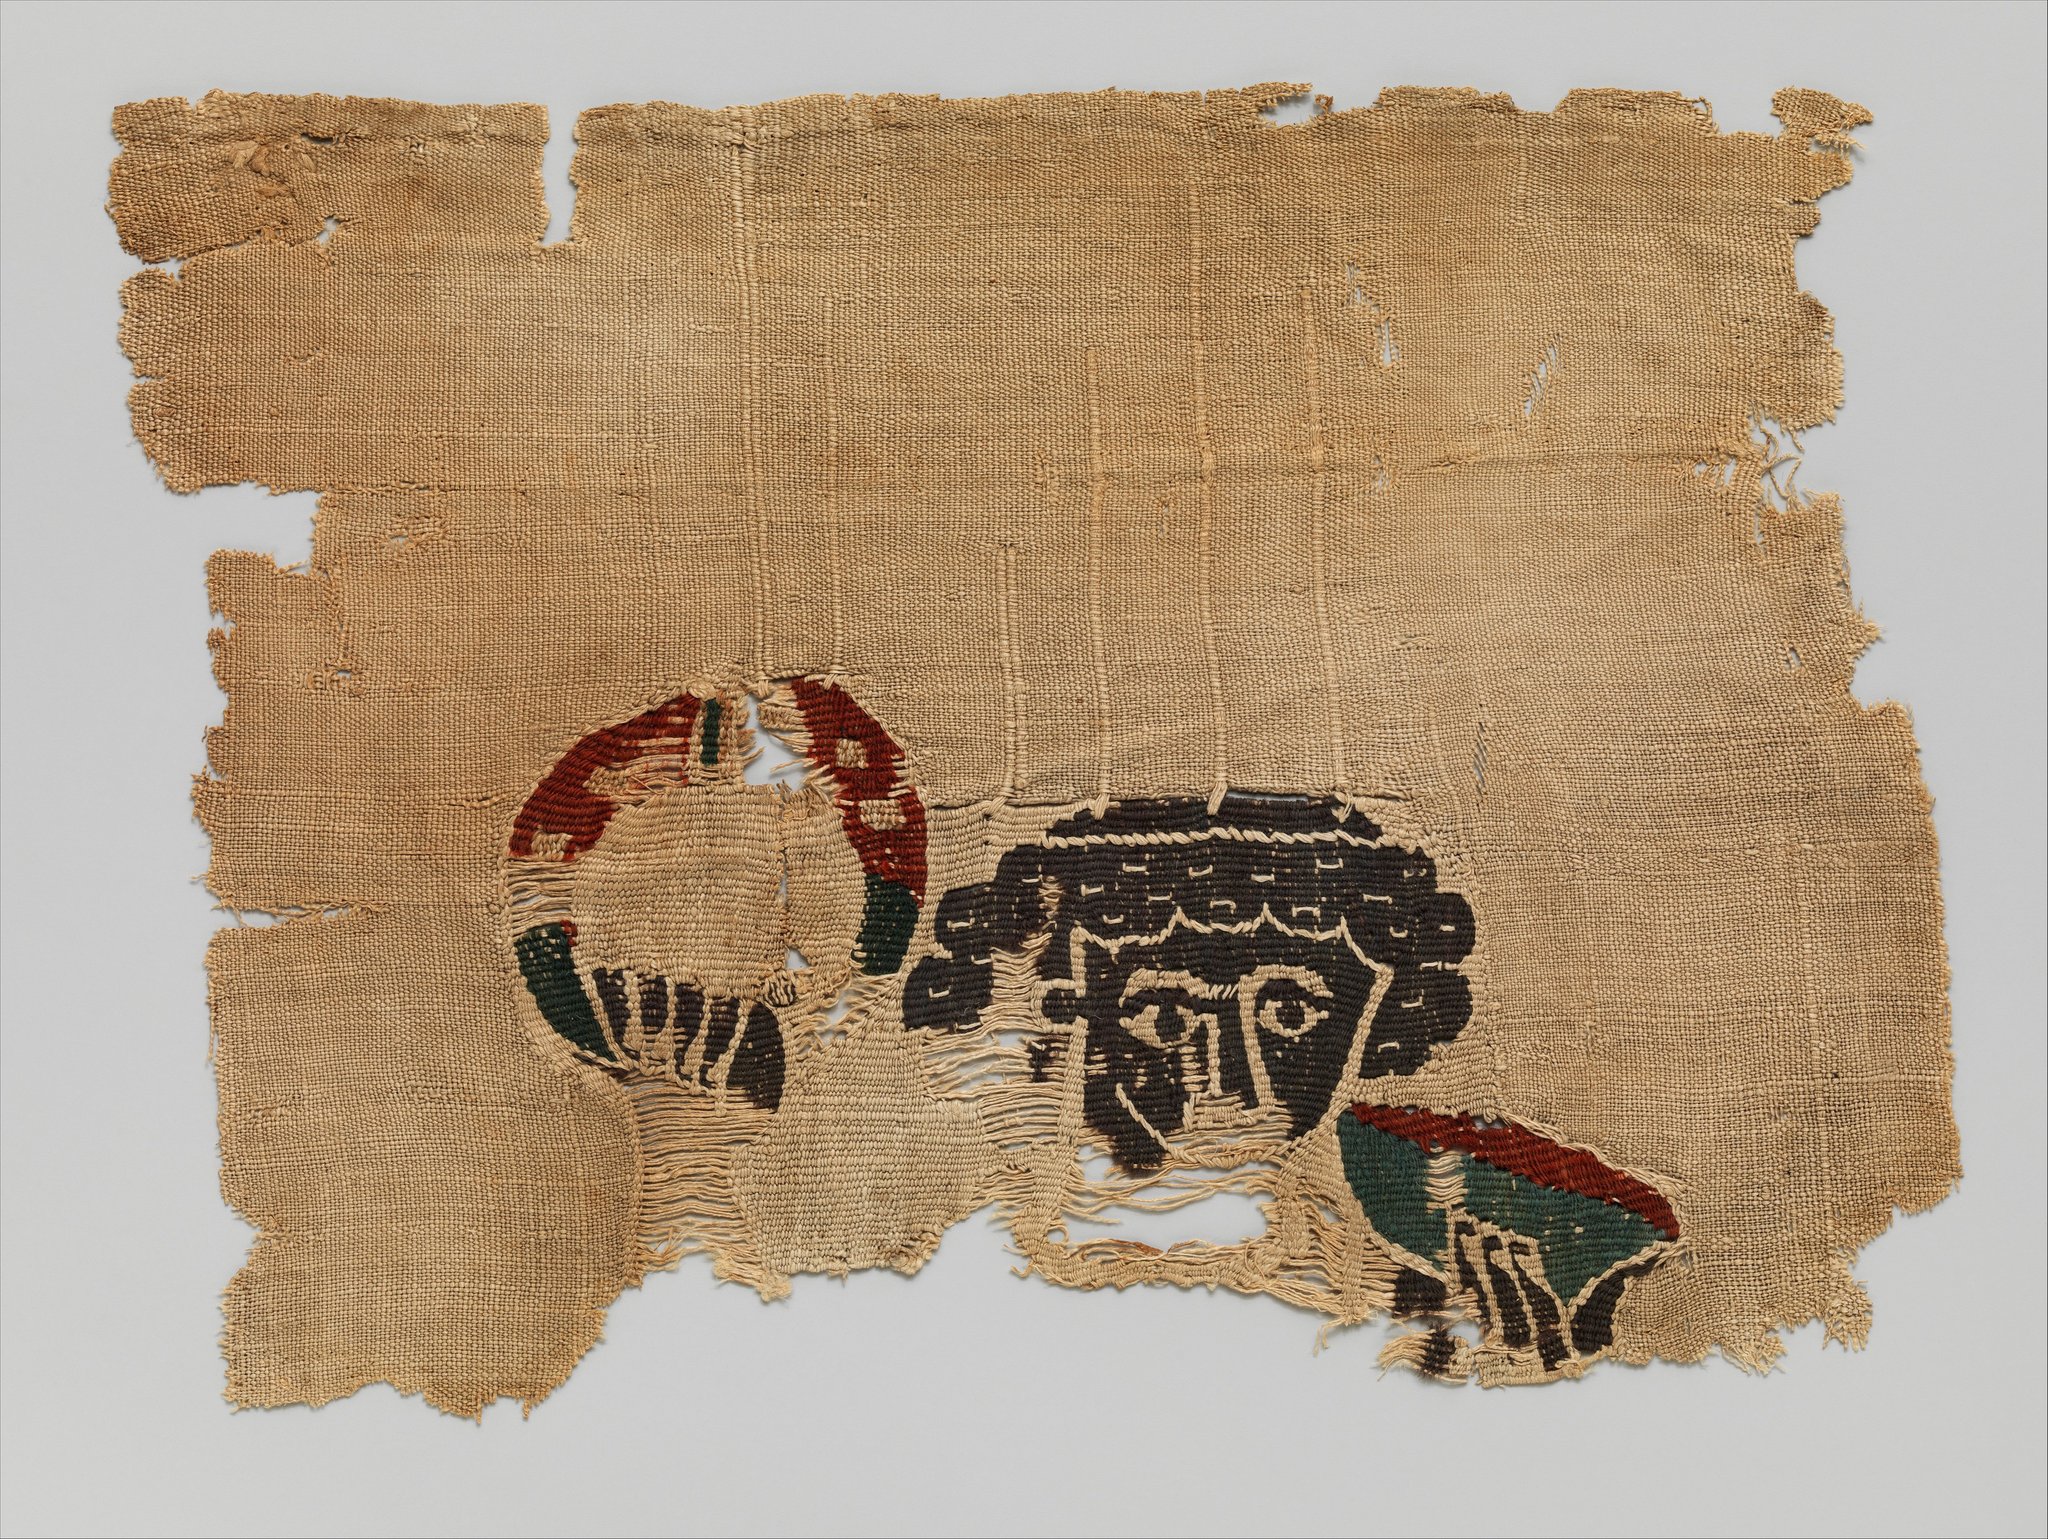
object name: textile fragment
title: Fragment with the Head of a Figure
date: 301-600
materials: linen, wool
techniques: weave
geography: egypt